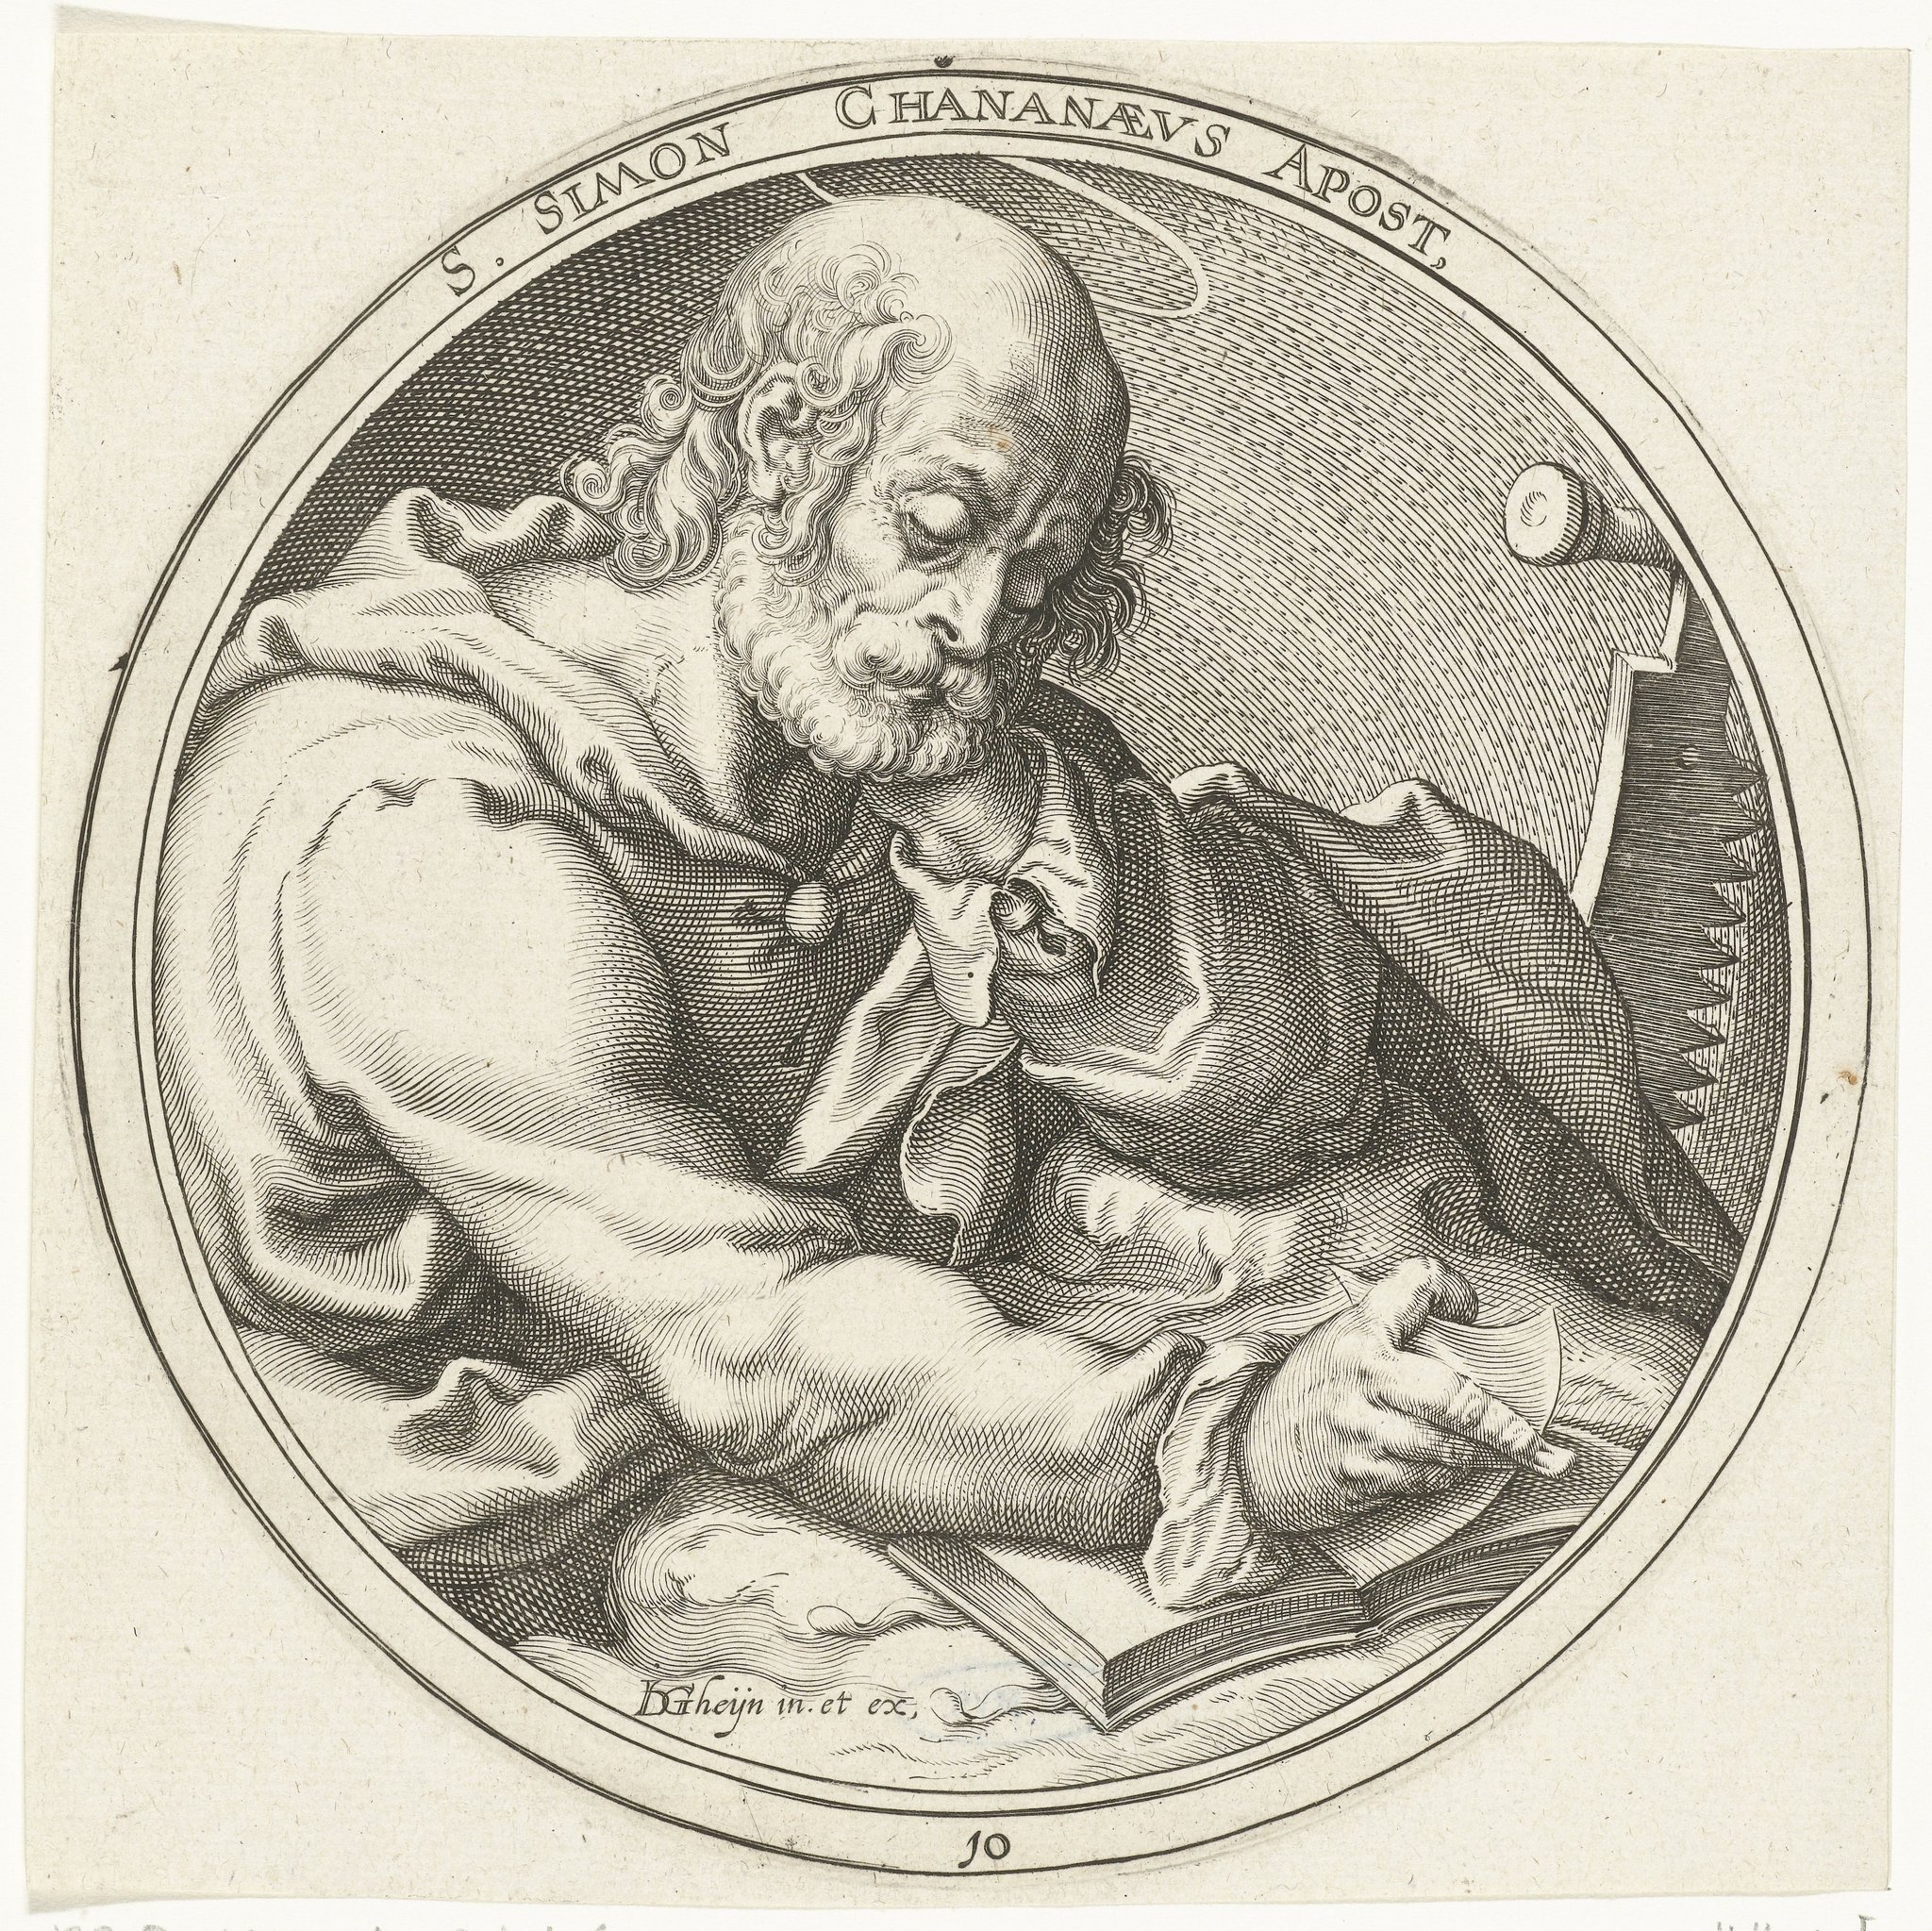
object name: print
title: Christus, de apostelen en de H. Paulus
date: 1596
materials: paper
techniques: engraving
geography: leiden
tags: the apostle simon zelotes (or simon the canaanite); possible attributes: book, saw, scroll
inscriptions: collector's mark: Lugt 2228